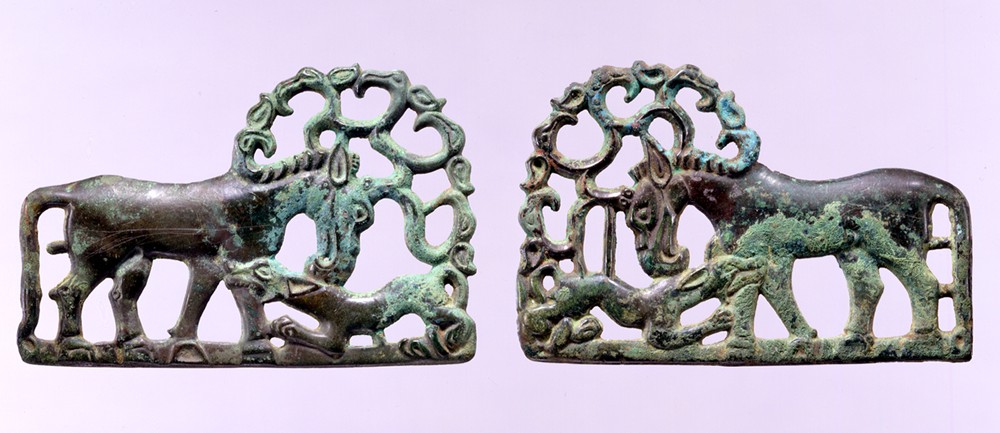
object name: belt buckle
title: Belt Buckle with Animal-Combat Scene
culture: chinese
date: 300-101 BCE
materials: bronze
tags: animals